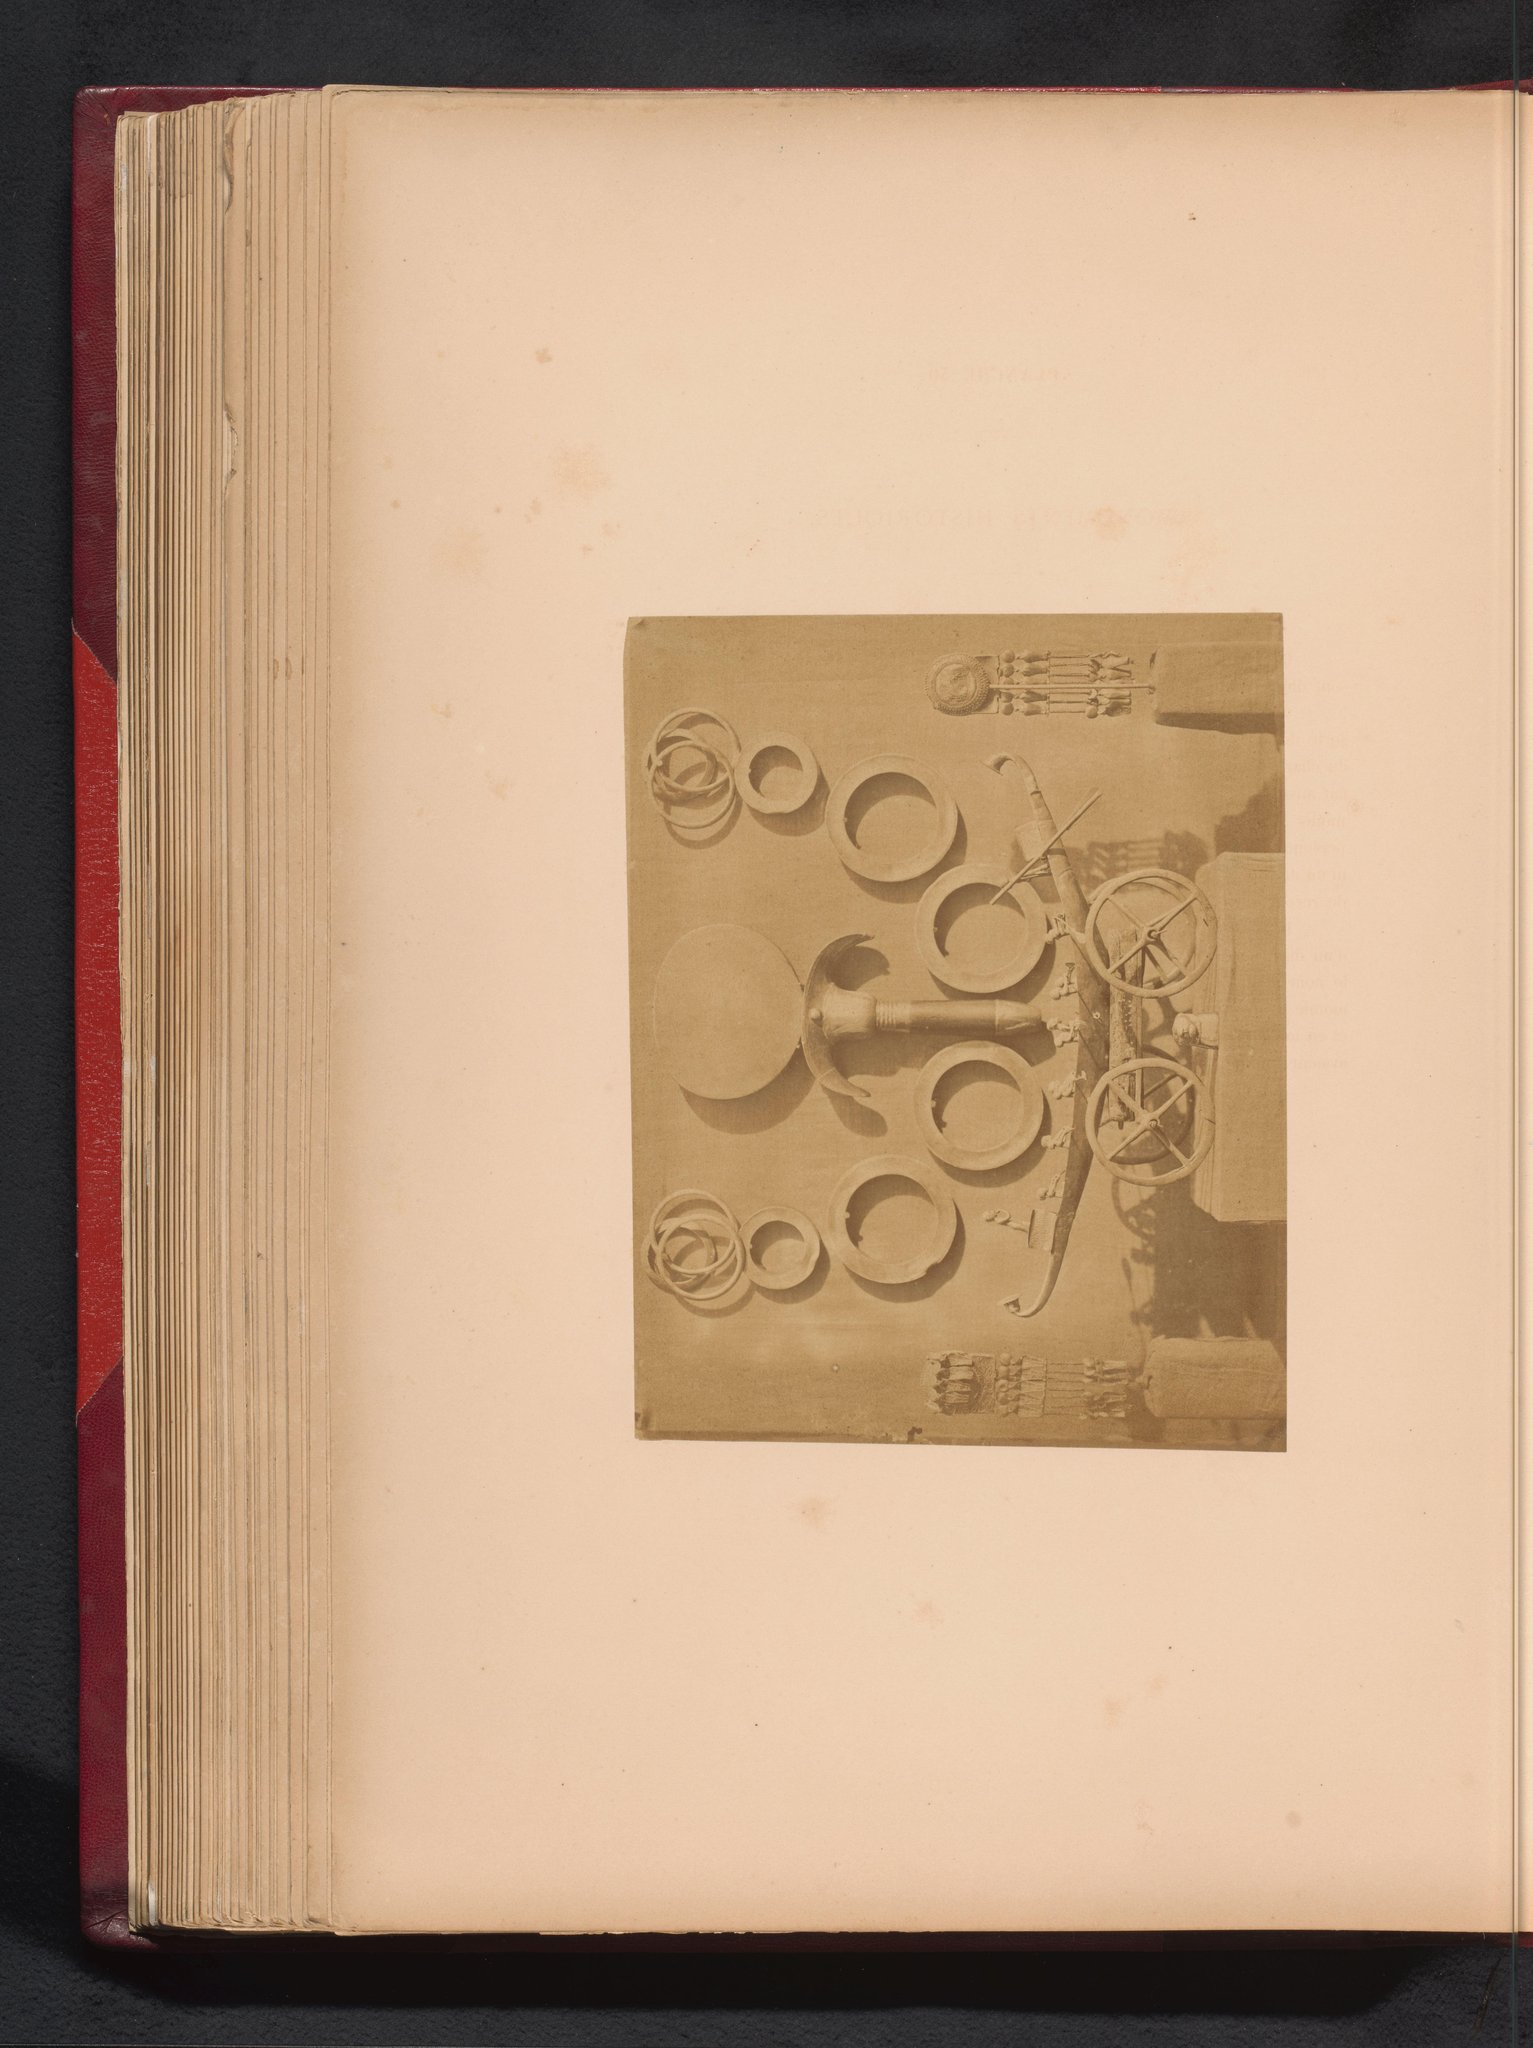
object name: page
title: Sieraden gevonden in Abydos, opgesteld in het Boulaq Museum in Caïro, Egypte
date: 1866-1871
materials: photographic support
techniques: albumen print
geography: cairo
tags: ornaments, jewels, permanent exhibition, museum